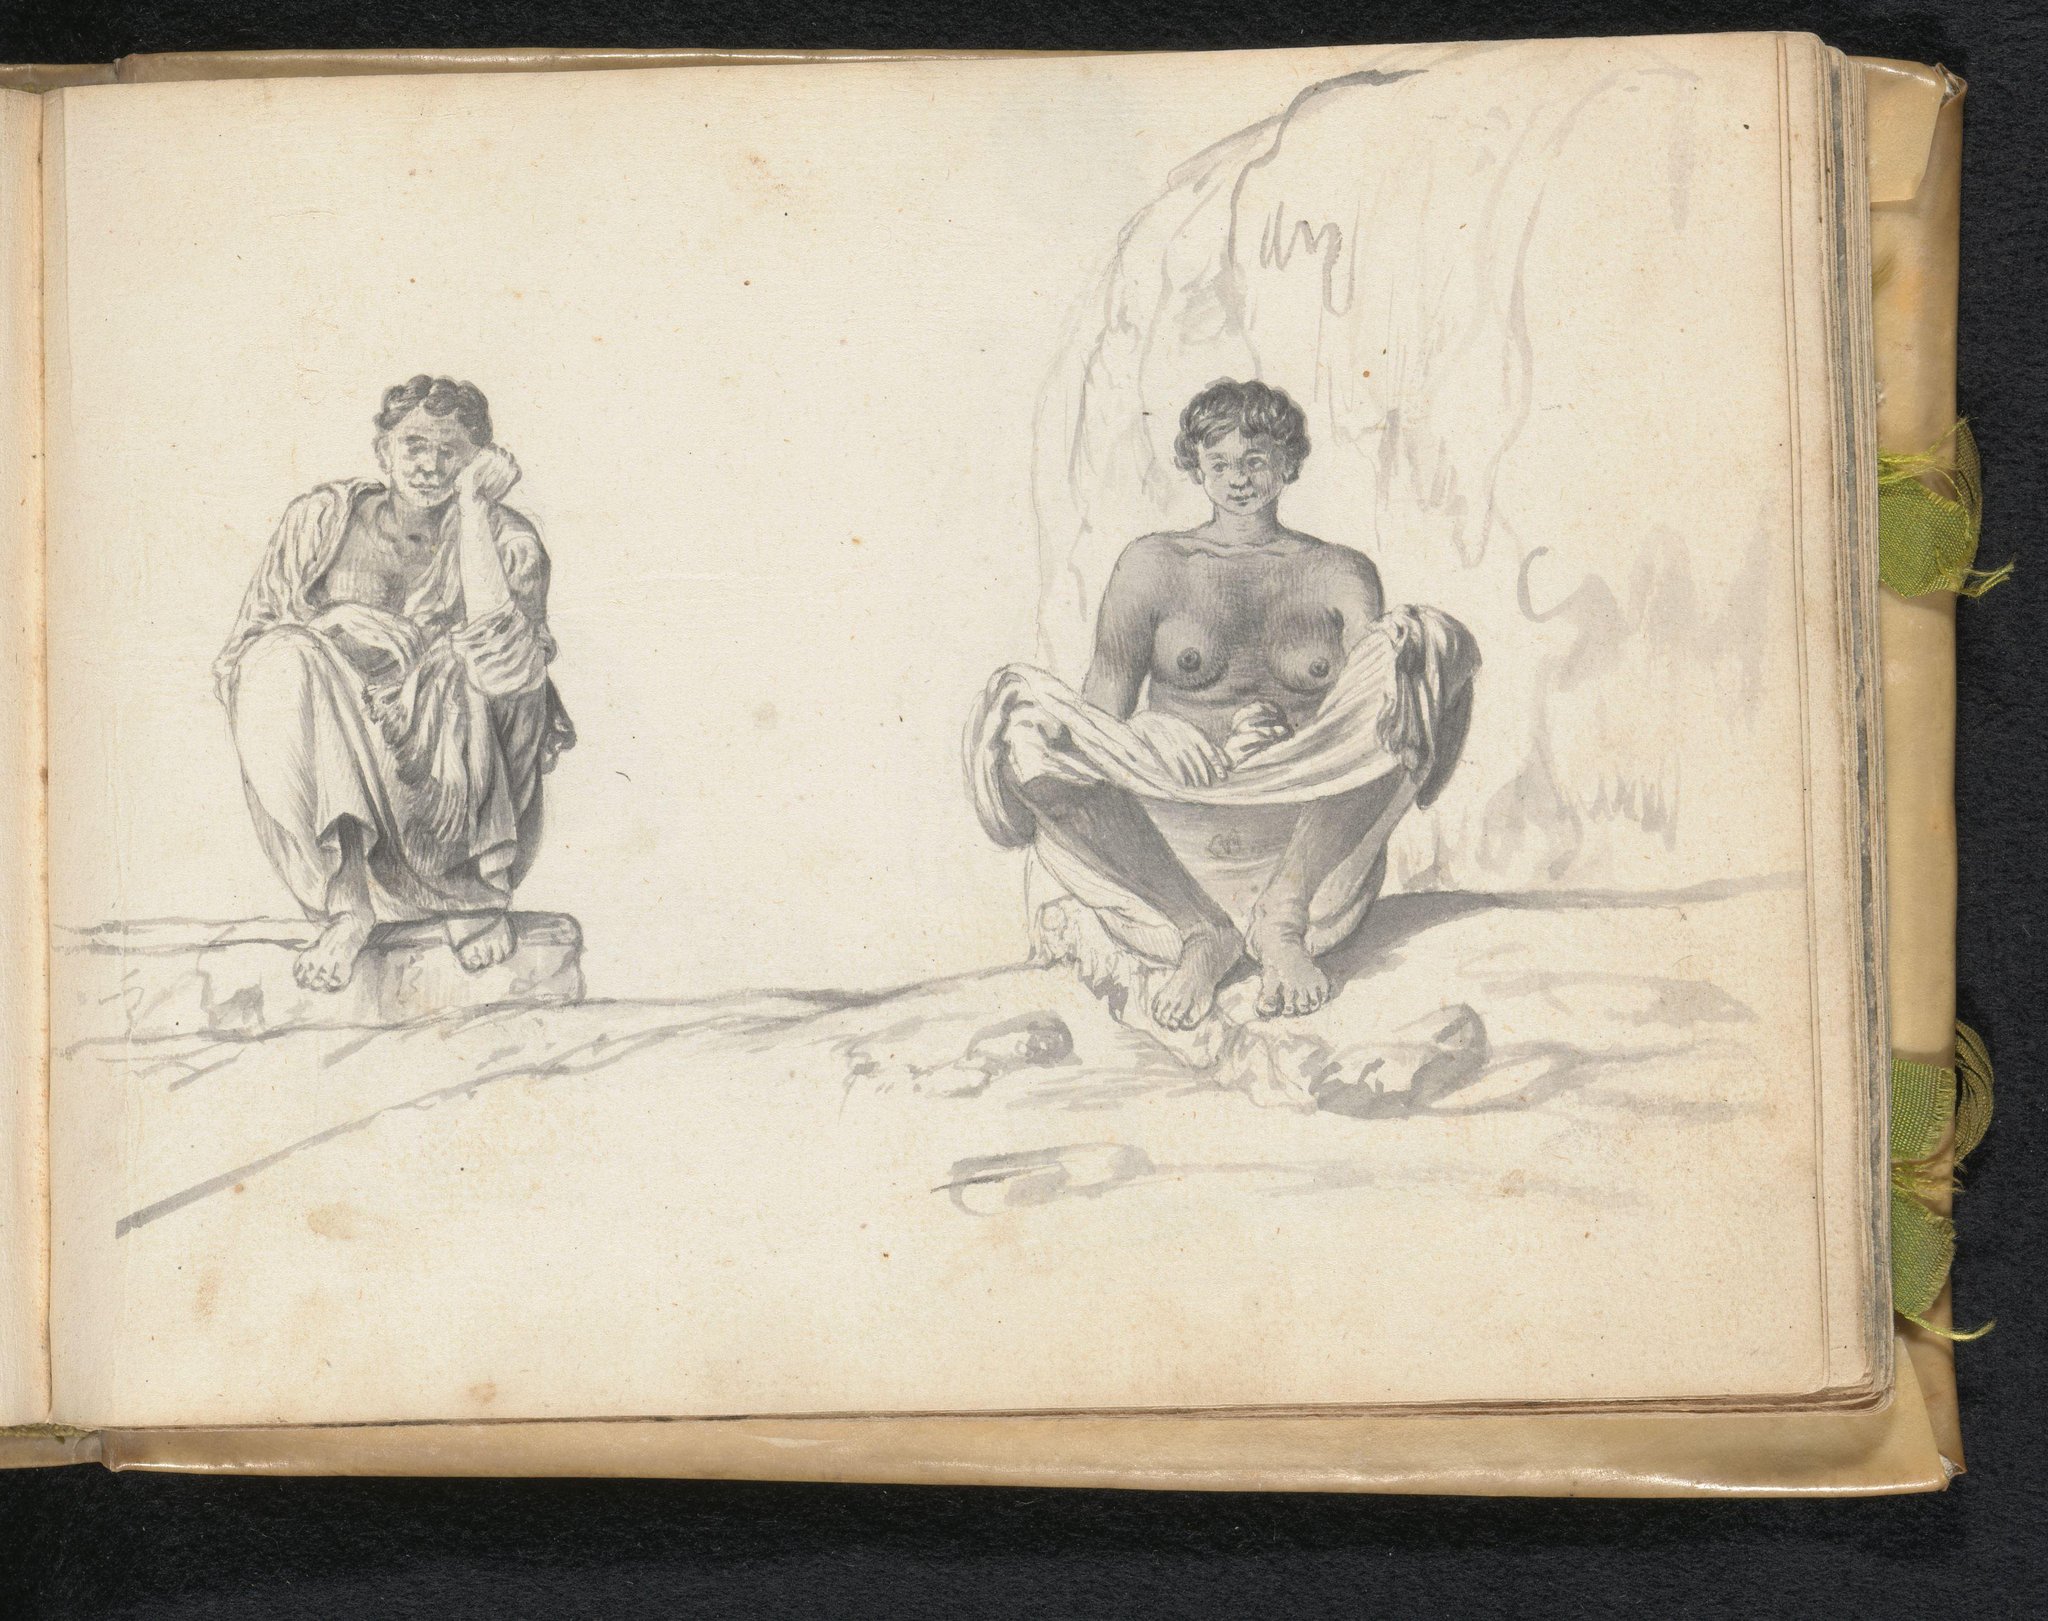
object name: sketchbook leaf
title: Two sitting labourers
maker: esaias boursse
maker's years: 1631-1672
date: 1662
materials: ink, paper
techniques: brush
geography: sri lanka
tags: 41d232(...) skirt (lungi), clothing for the upper part of the body (with name), working class, labourers, asiatic races and peoples: indians, sri lanka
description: Buiten op een oplopende oneffen grond zitten twee mannen. De man links zit gehurkt op een verhoogde stenen stoep. Hij draagt een heupkleed (veshti, lungi) tot over de knieën en een openhangend hemd met lange mouwen waarvan de gerafelde onderrand over zijn knie ligt. De man rechts zit met gespreide gebogen knieën naast een straatrand op de grond, en leunt met zijn rug tegen een rotspartij. Ook hij draagt een lang heupkleed, opgetrokken tot op de knie. Blad 91 uit een schetsboek met 117 bladen.